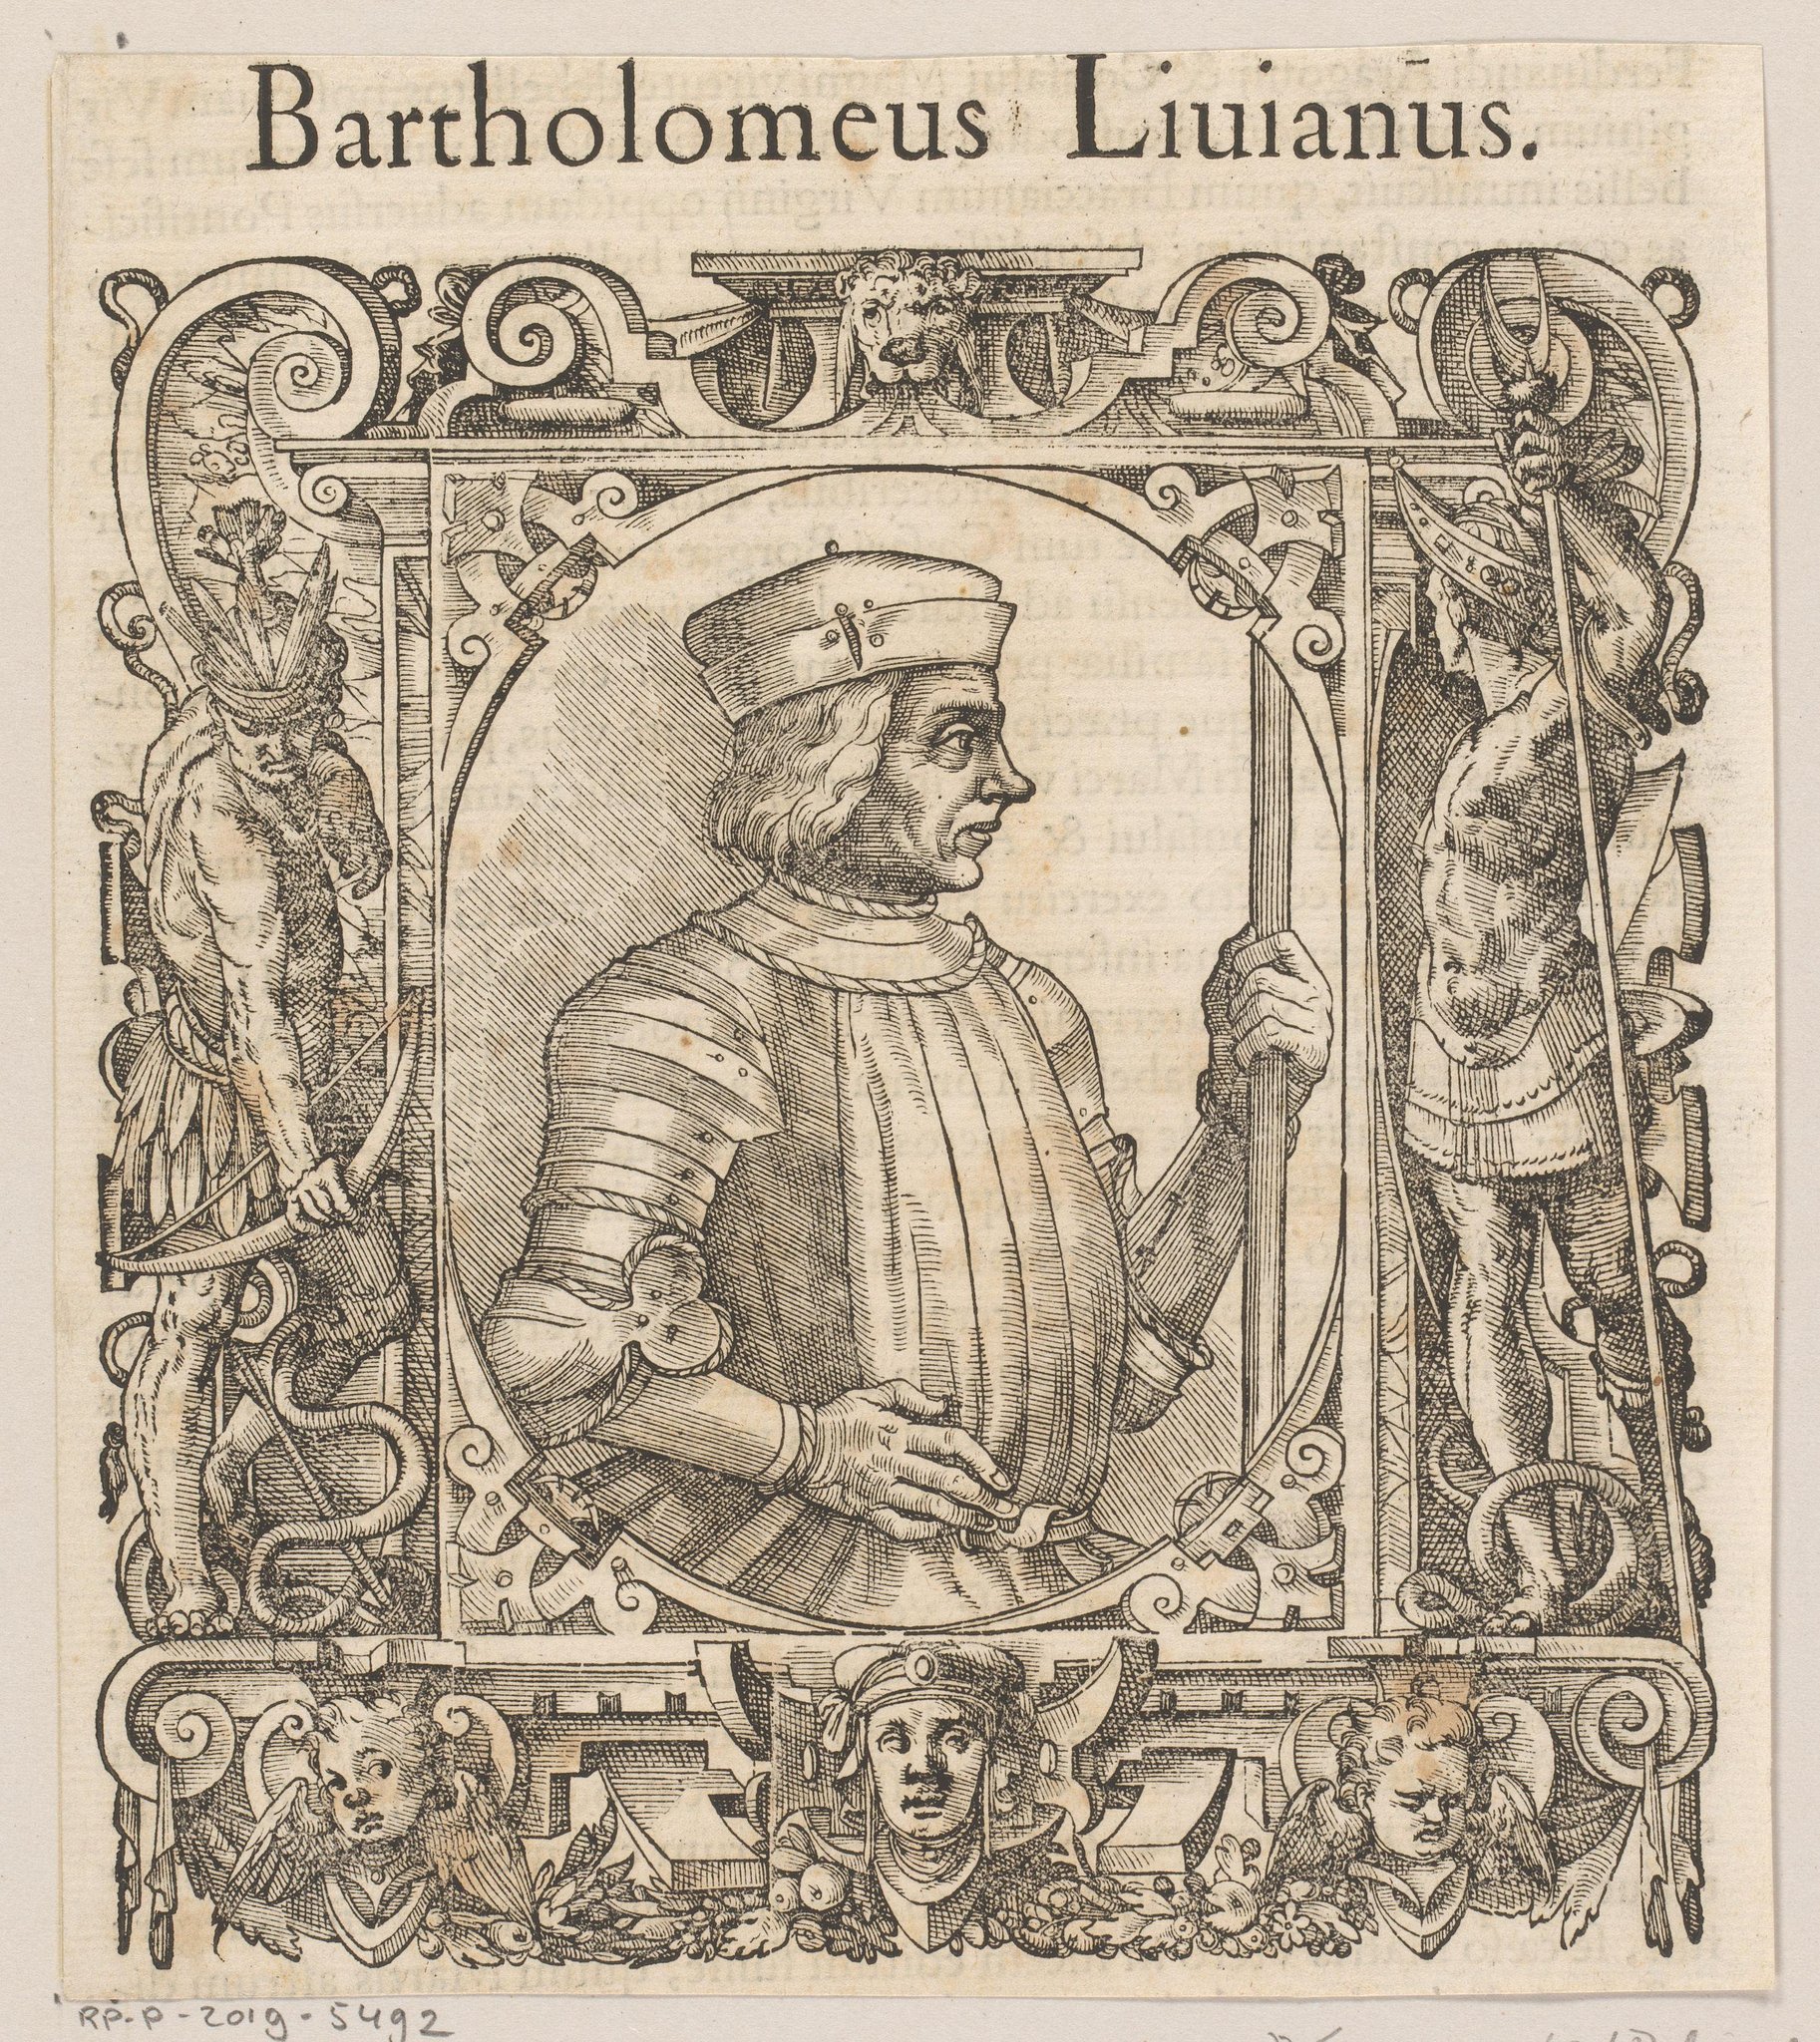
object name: print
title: Portret van Bartolomeo d'Alviano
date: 1575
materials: paper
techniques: letterpress printing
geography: basel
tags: armour, historical persons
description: Prent uit: Giovio, Paolo. Elogia virorum bellica virtute illustrium (...). Bazel: Peter Perna, 1575, p. 219. Prent ook gebruikt in latere publicaties.